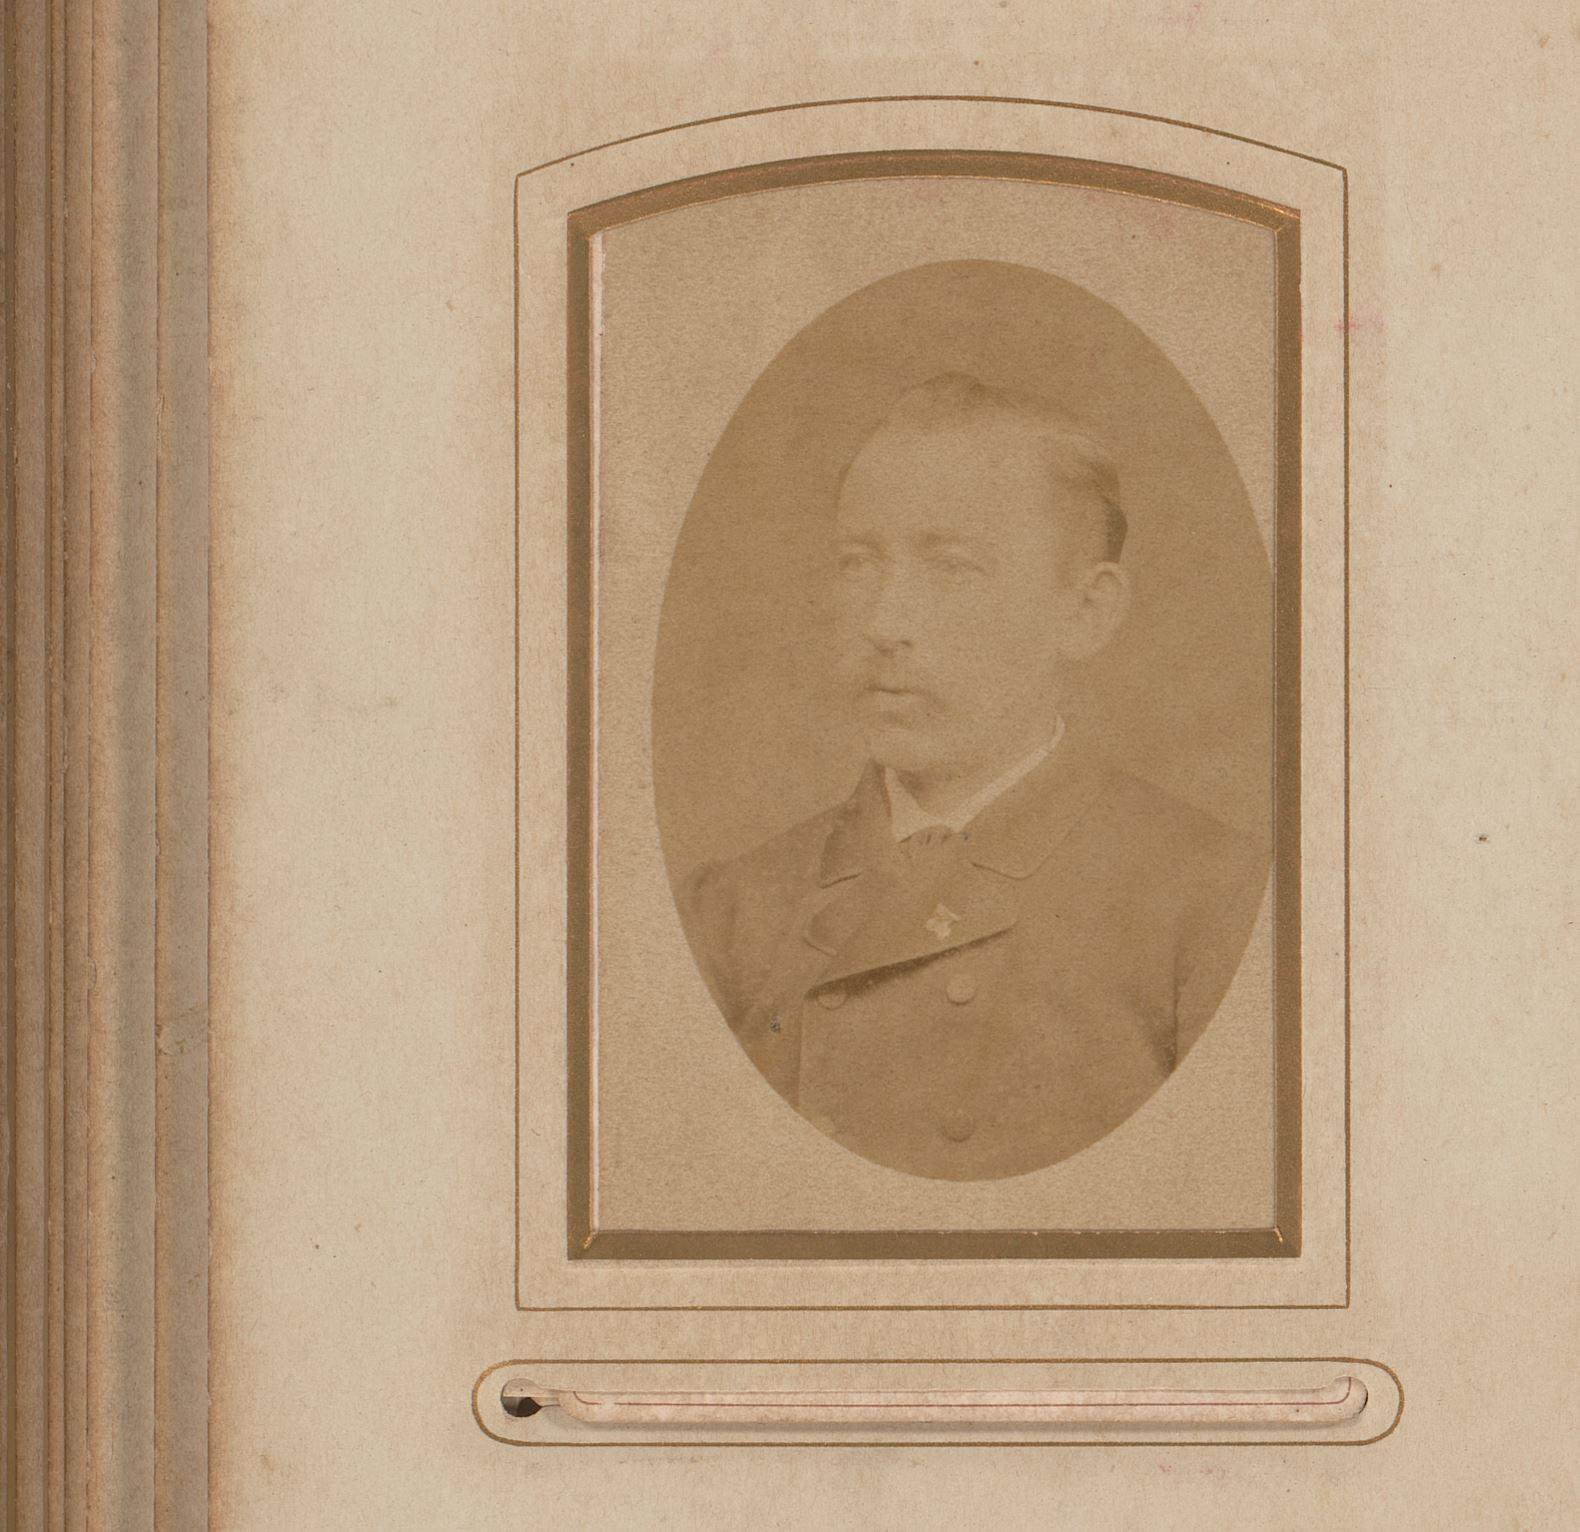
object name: album leaf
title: Portret van een man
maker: george lodewijk mulder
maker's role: fotograaf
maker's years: 1841-1920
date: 1859-1898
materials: cardboard, photographic support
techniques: albumen print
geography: utrecht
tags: sitting figure, historical persons, infant, baby ~ the ages of man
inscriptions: inscription: ‘G. L. MULDER/ (...)/ van Wijekskade H. 326./ UTRECHT.’